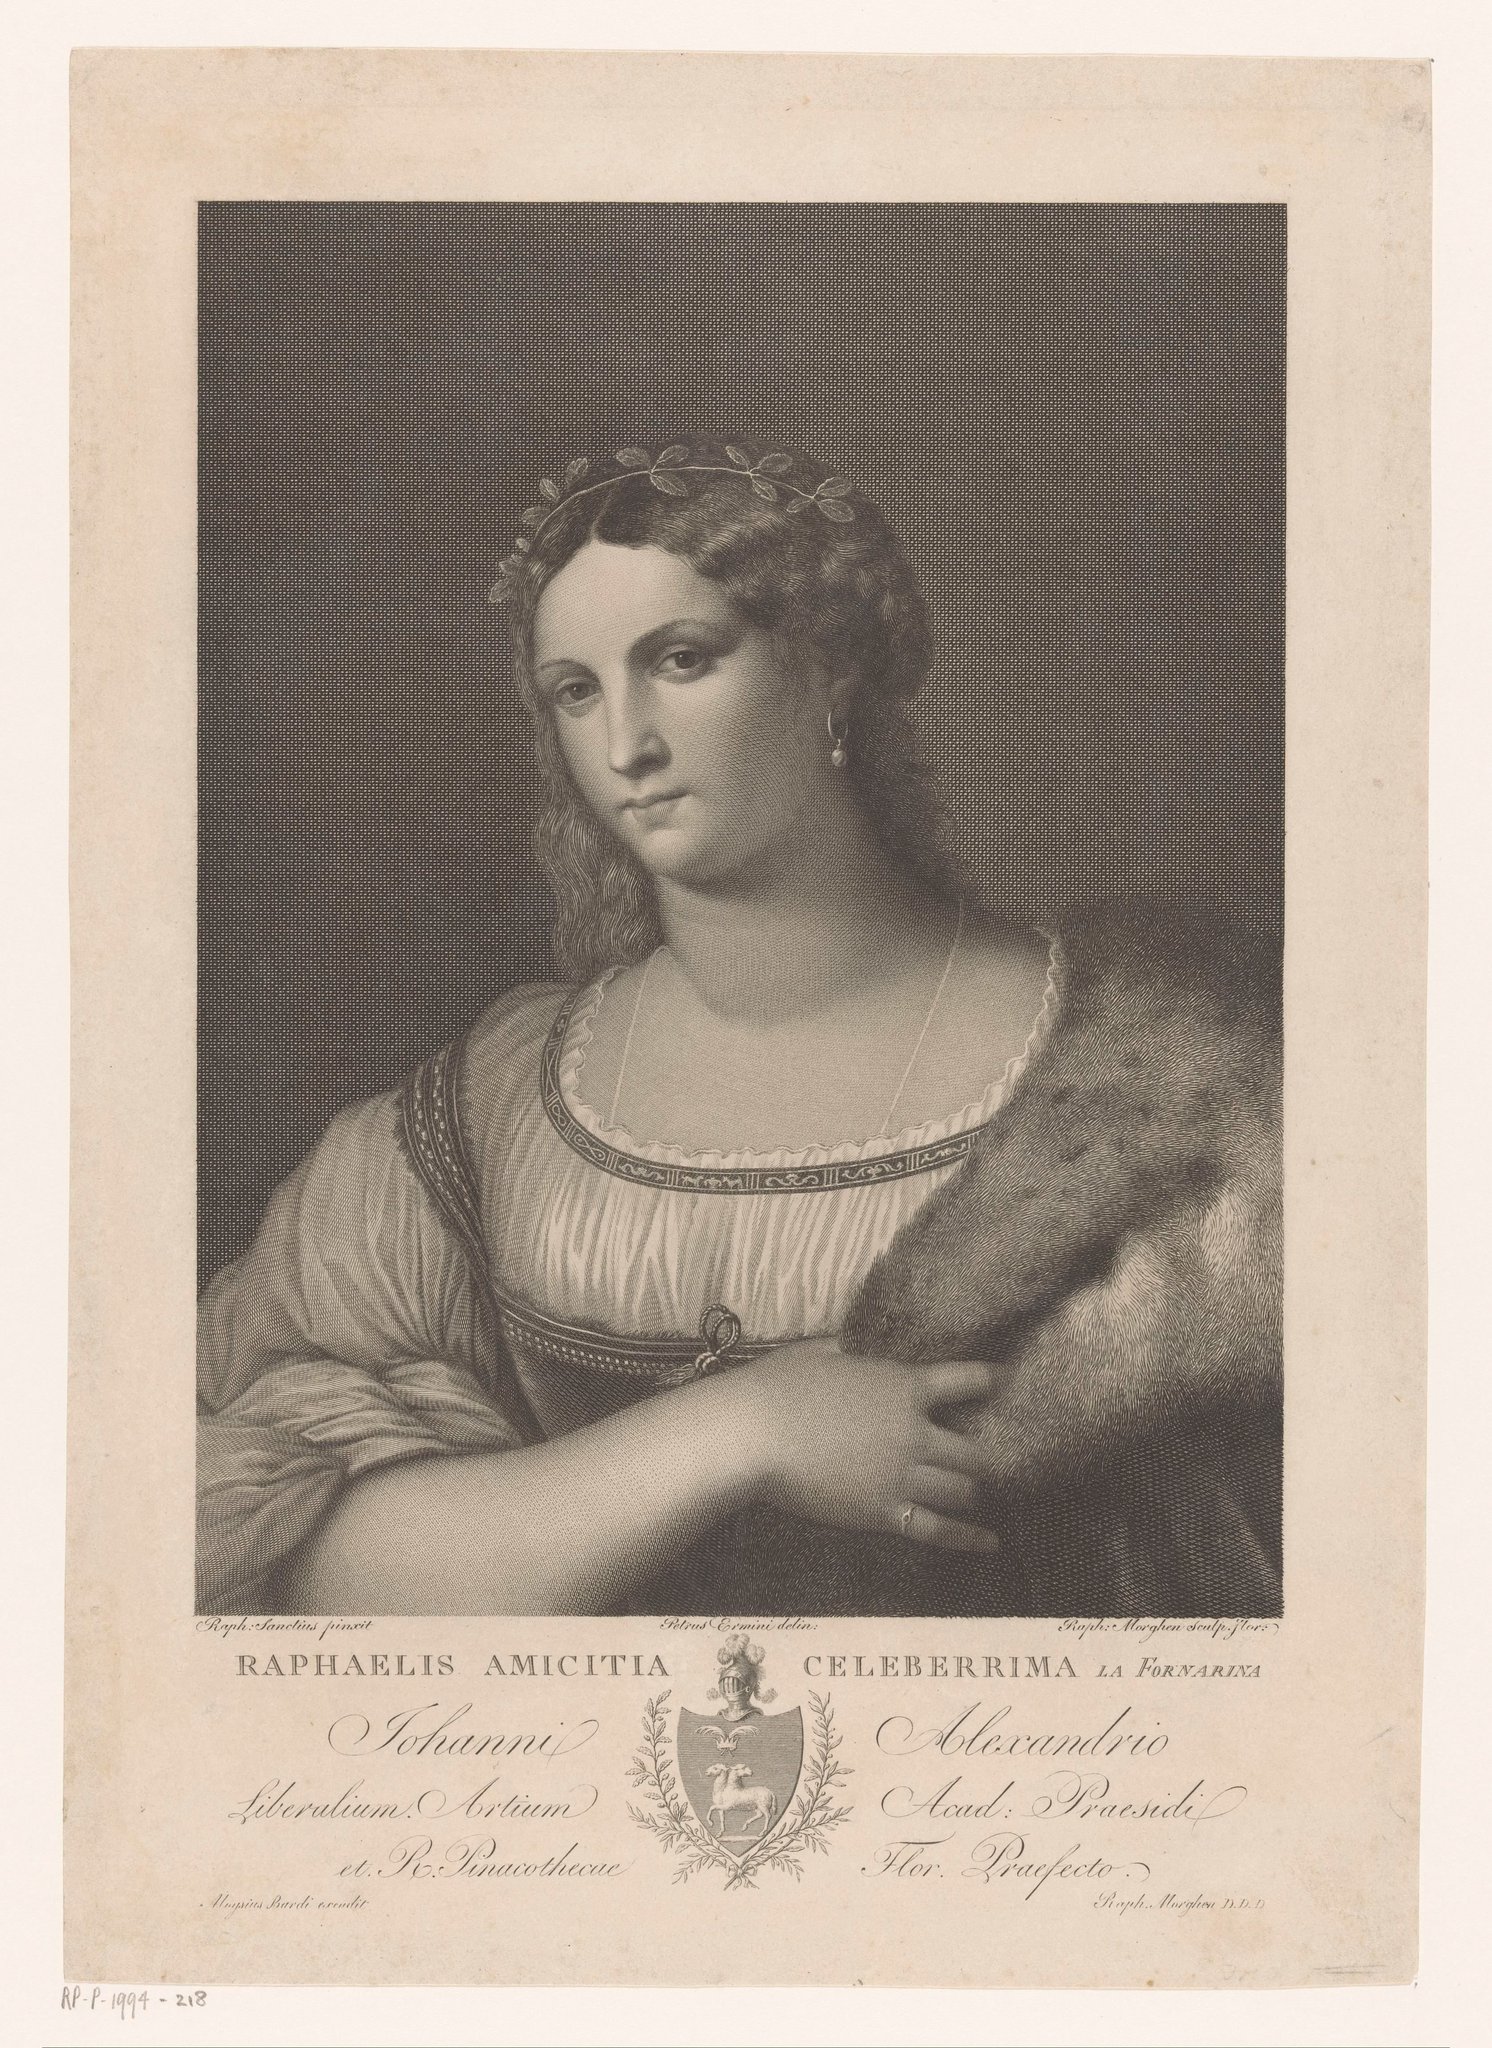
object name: print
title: Raphaelis Amicitia Celeberrima la Fornarina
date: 1768-1833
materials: paper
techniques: engraving, etching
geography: italy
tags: anonymous historical person portrayed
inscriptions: collector's mark: Lugt 3428, collector's mark: Lugt 2228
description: Naar een portret door Sebastiano del Piombo, dat vroeger werd toegeschreven aan Rafaël. Het schilderij bevindt zich in de Galleria degli Uffizi te Florence.